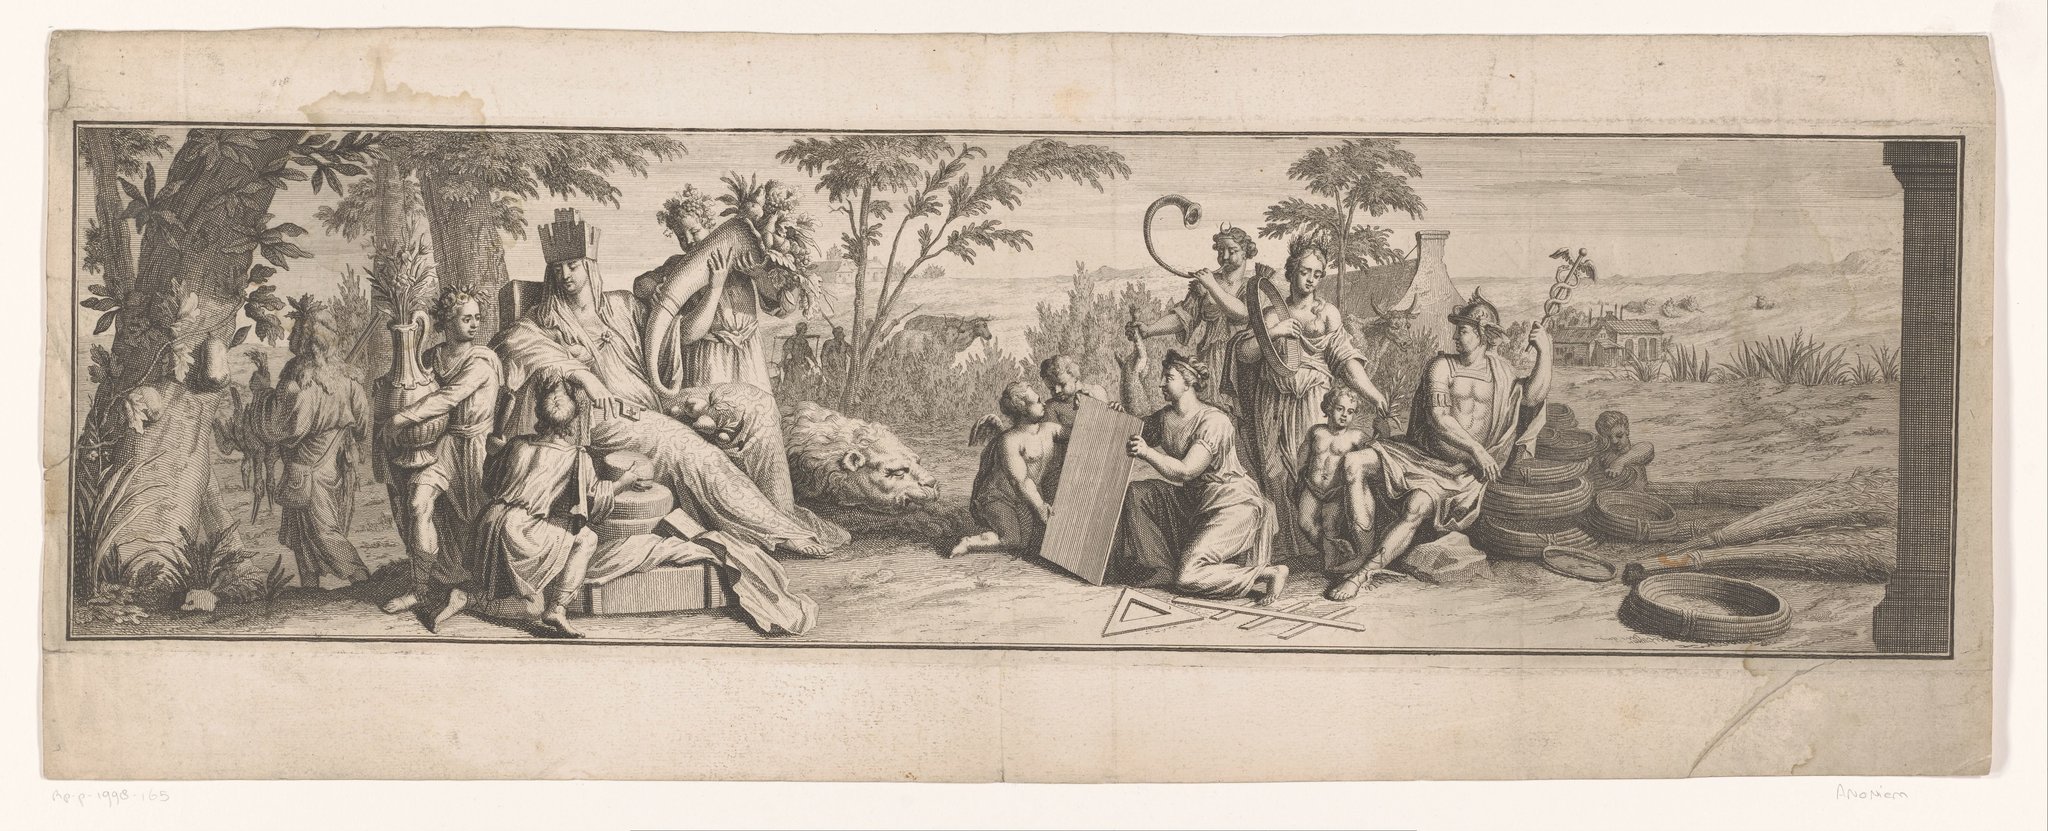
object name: print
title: Stedenmaagd en goden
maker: Anonymous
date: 1680-1750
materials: paper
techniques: engraving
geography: northern netherlands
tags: personification of a city, town-patron(ess), roman deities, and foreign deities included in the classical pantheon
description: Links in een landschap zit een stedenmaagd op een troon. Voor haar knielt een jongeman met een fakkel. Zij wordt door figuren met de hoorn des overvloeds, een vaas met bloemen en een jachttrofee. Naast haar ligt een leeuw. Voor haar staan en zitten Diana, Ceres, Mercurius, Arithmetica en putti.